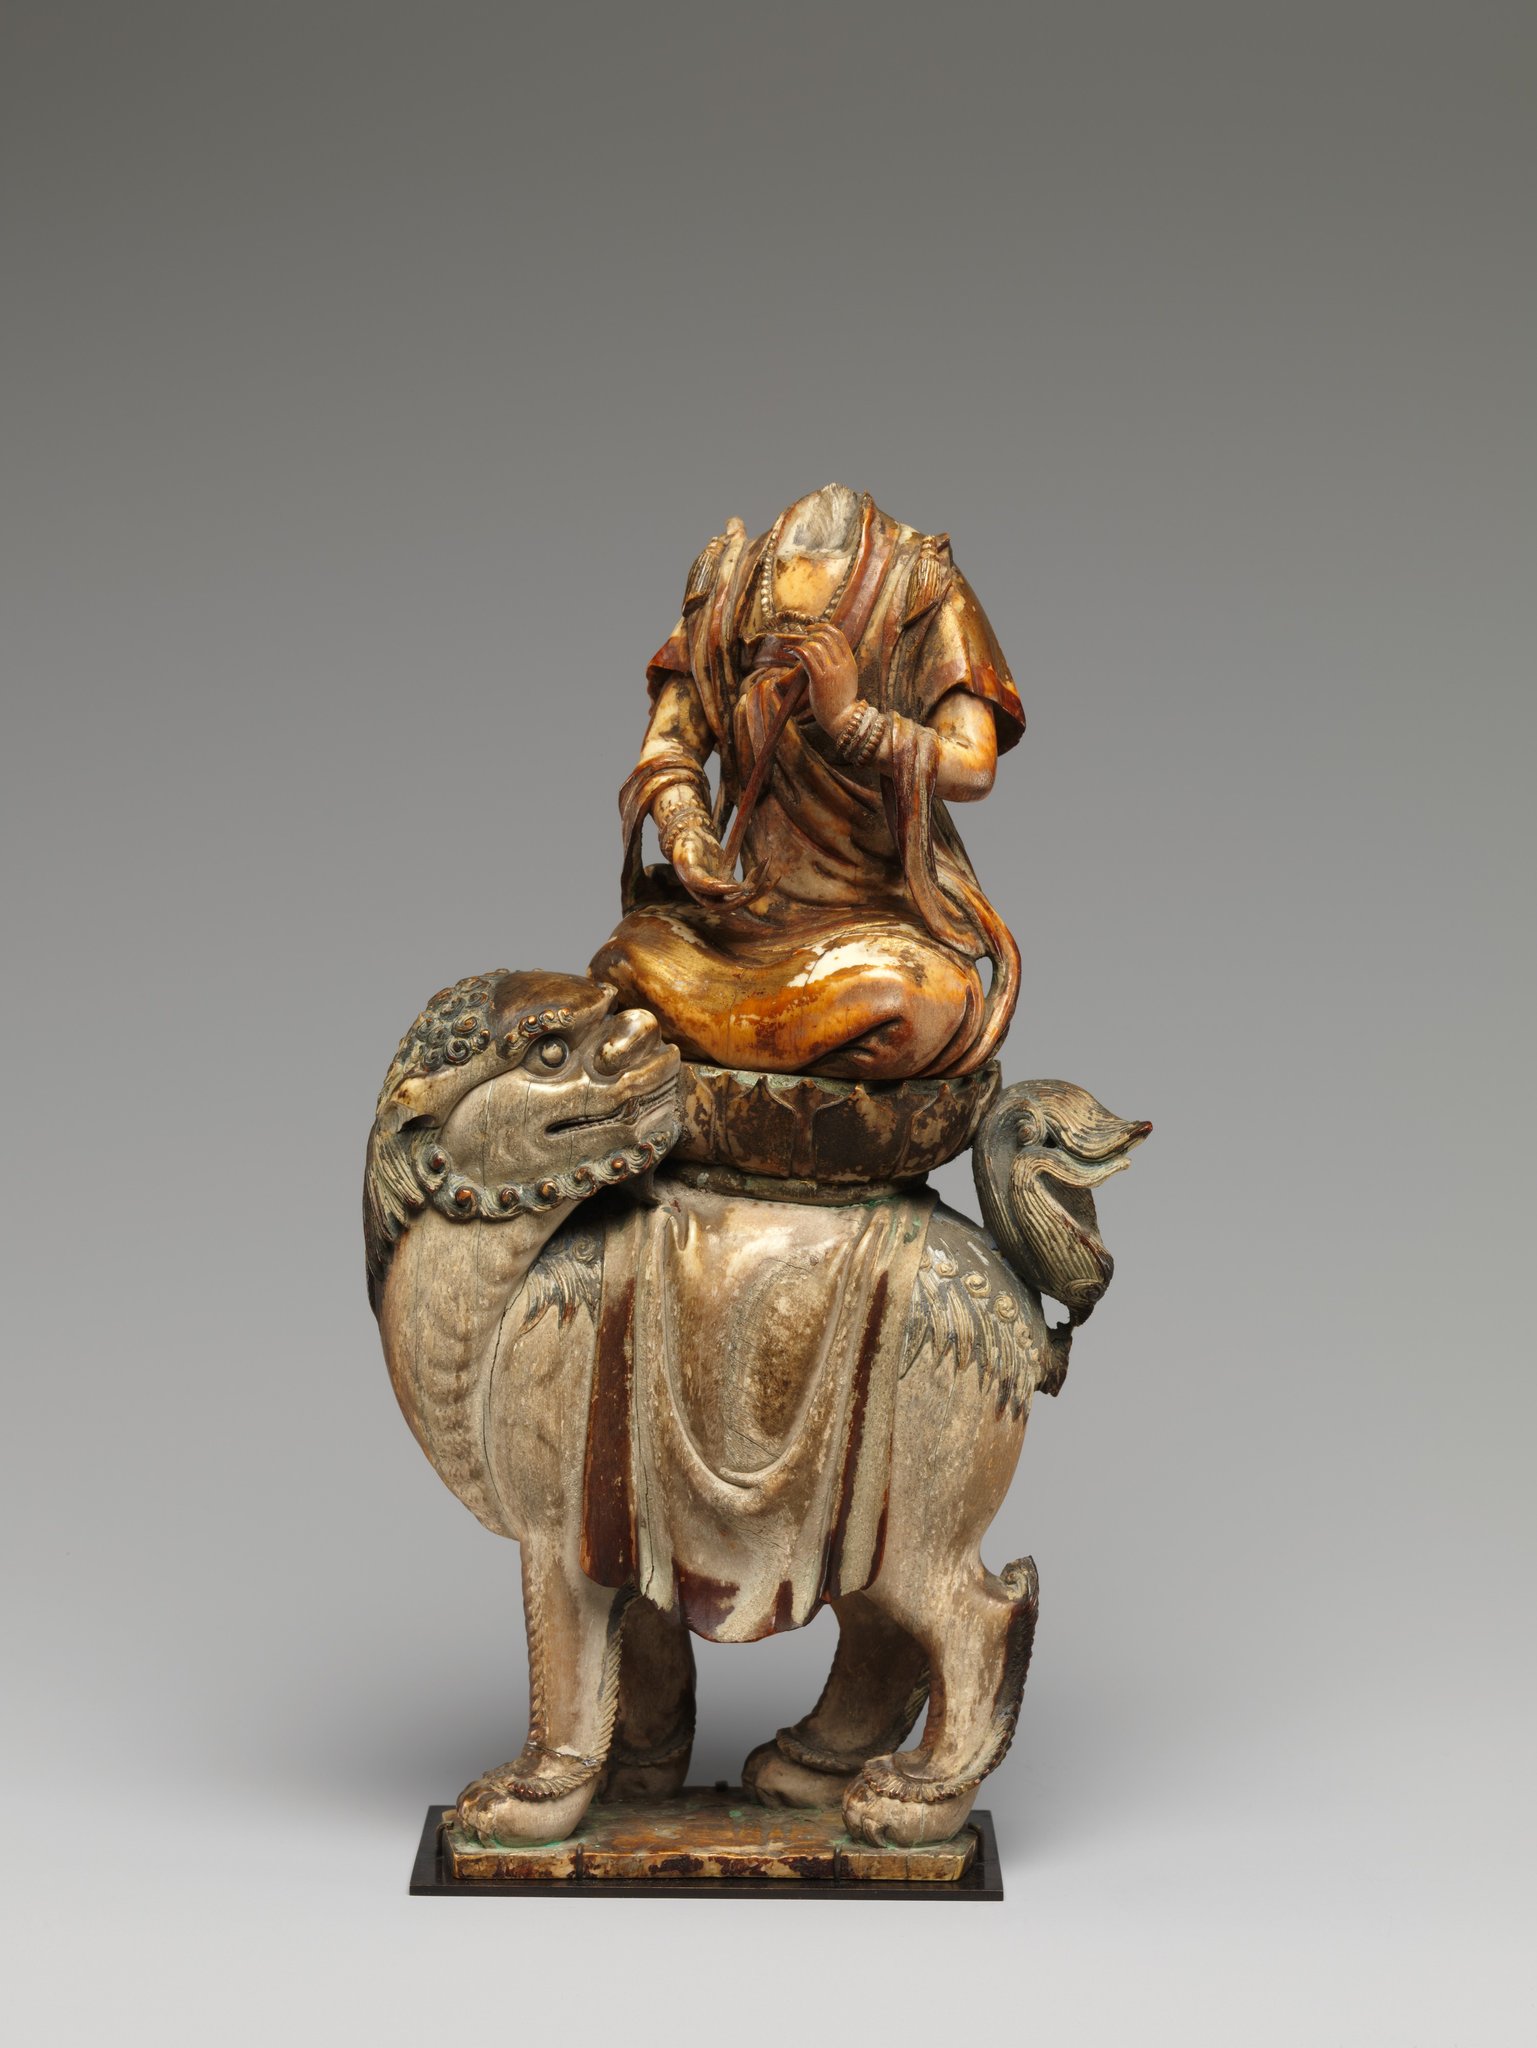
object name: headless figure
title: Bodhisattva Manjushri (Wenshu)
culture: chinese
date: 1101-1400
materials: ivory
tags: mythical creatures,buddhism,manjushri